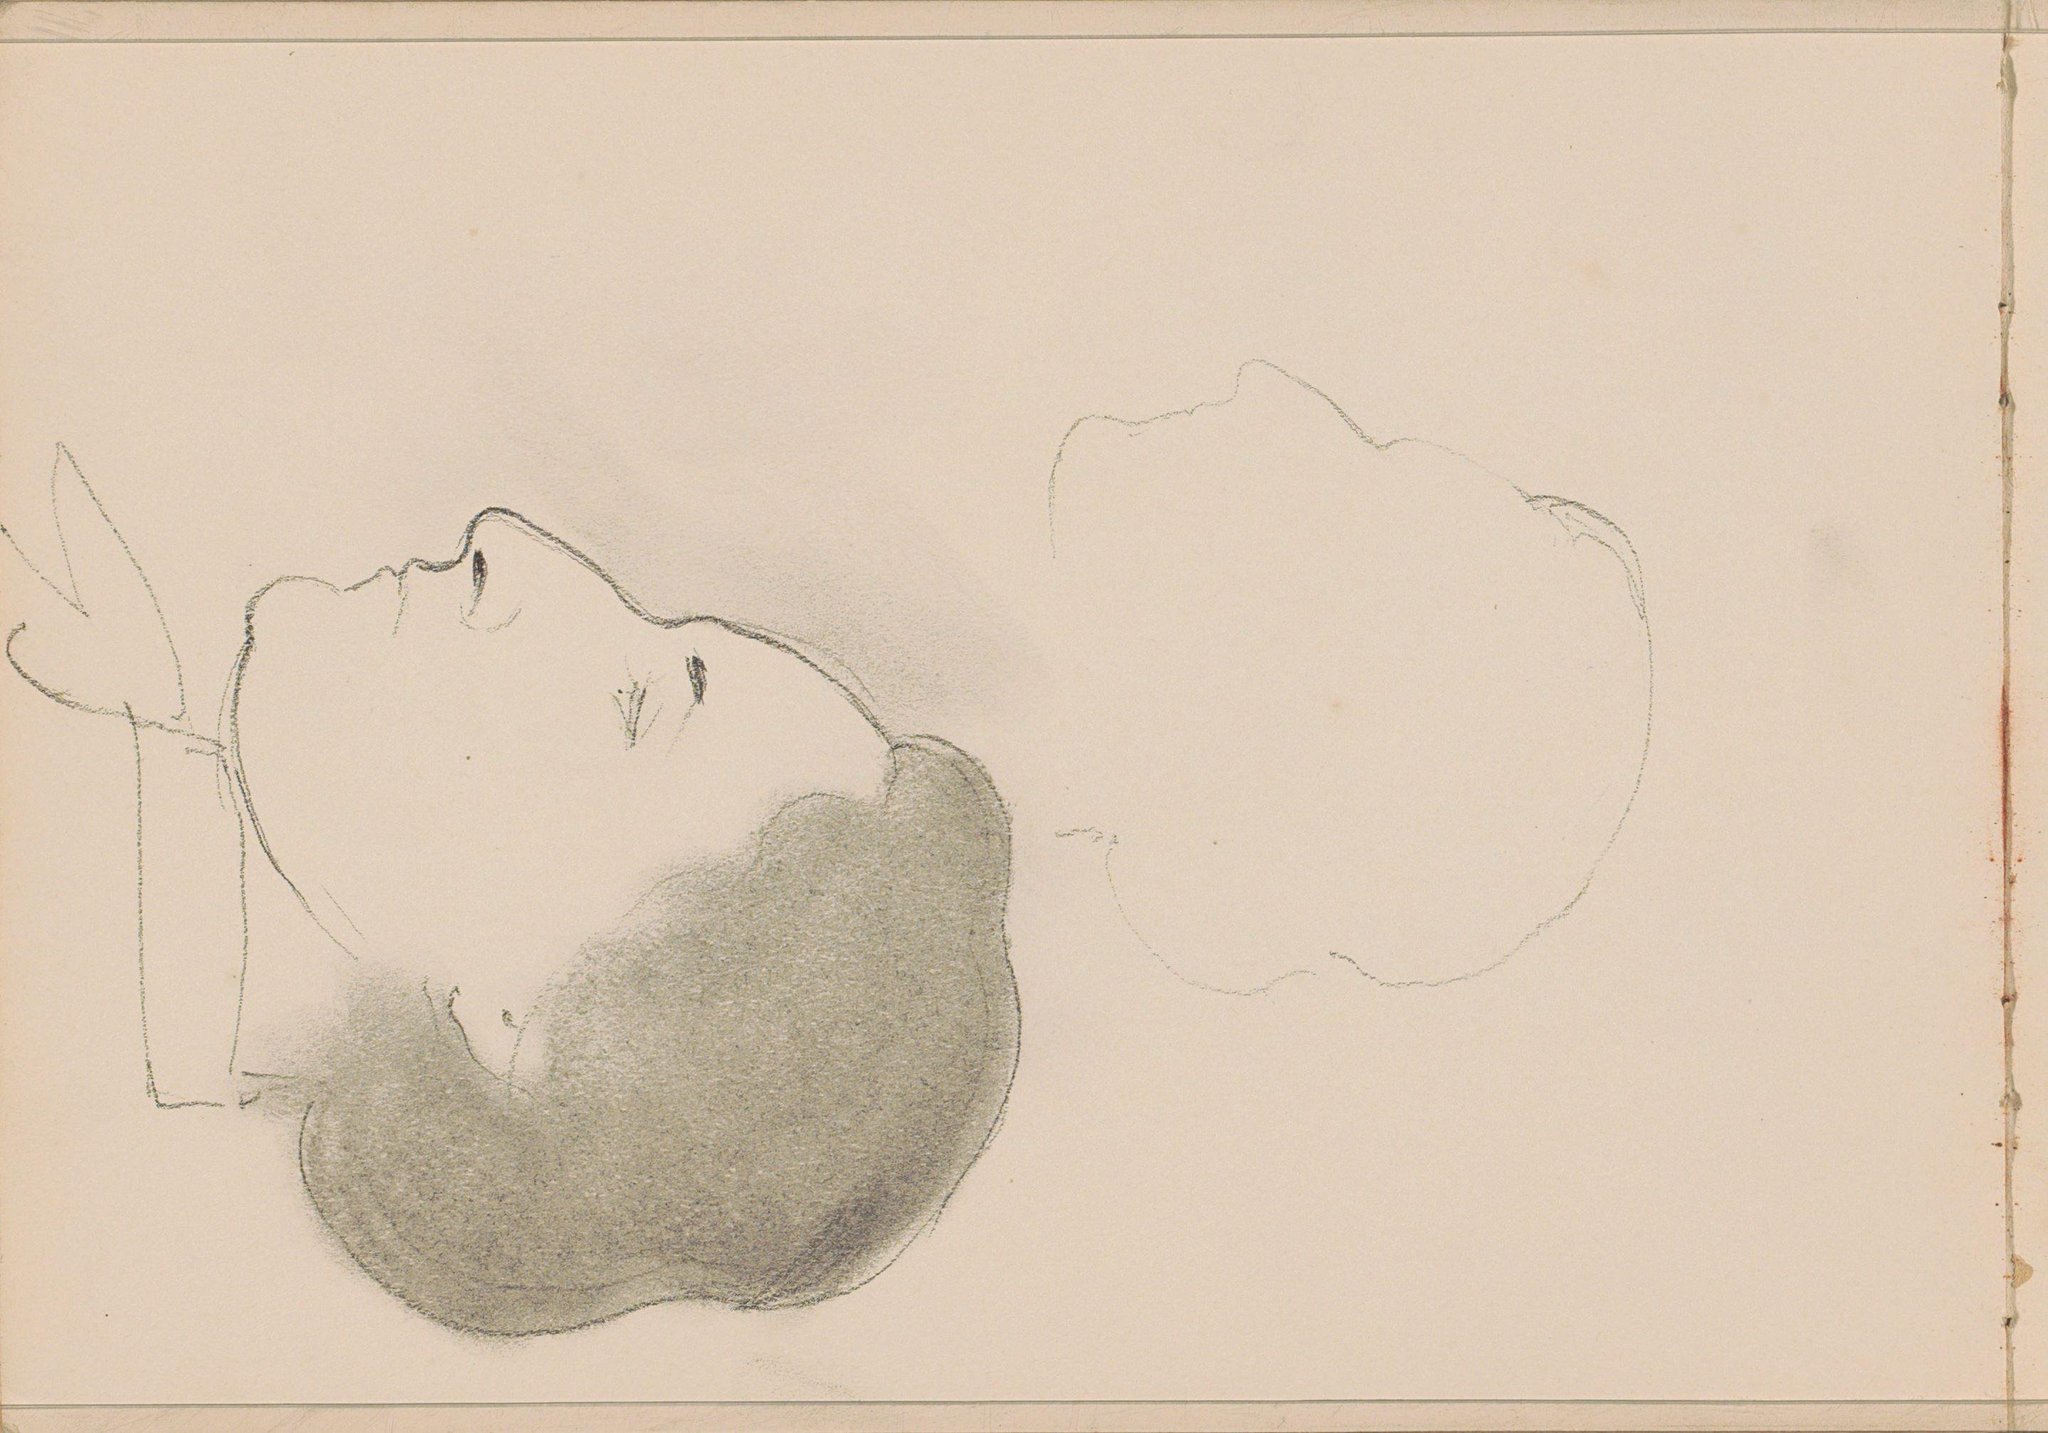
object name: sketchbook leaf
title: Kop van een vrouw, in profiel naar links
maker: a.a.l. de grammont-hubrecht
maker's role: draughtsman, painter, print maker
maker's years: 1855-1913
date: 1865-1913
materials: chalk, charcoal, paper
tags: head (human), adult woman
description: Blad 67 verso uit een schetsboek met 68 bladen.